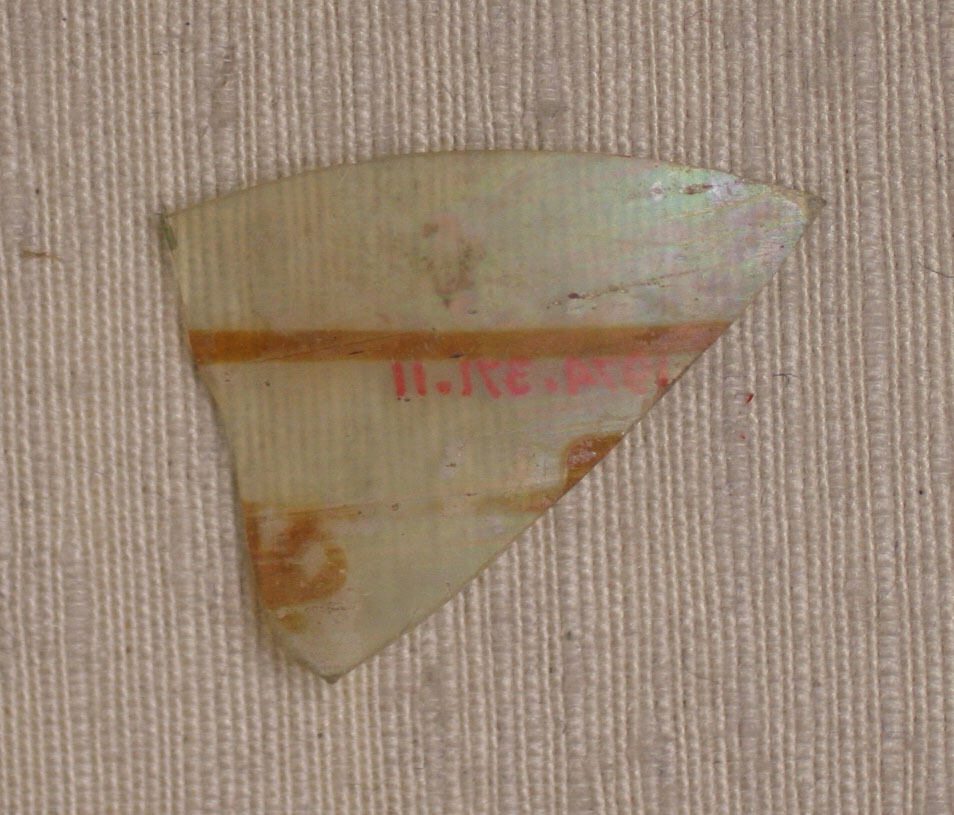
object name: fragment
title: Glass Fragment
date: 801-900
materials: glass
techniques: luster painting, stain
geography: egypt or iraq